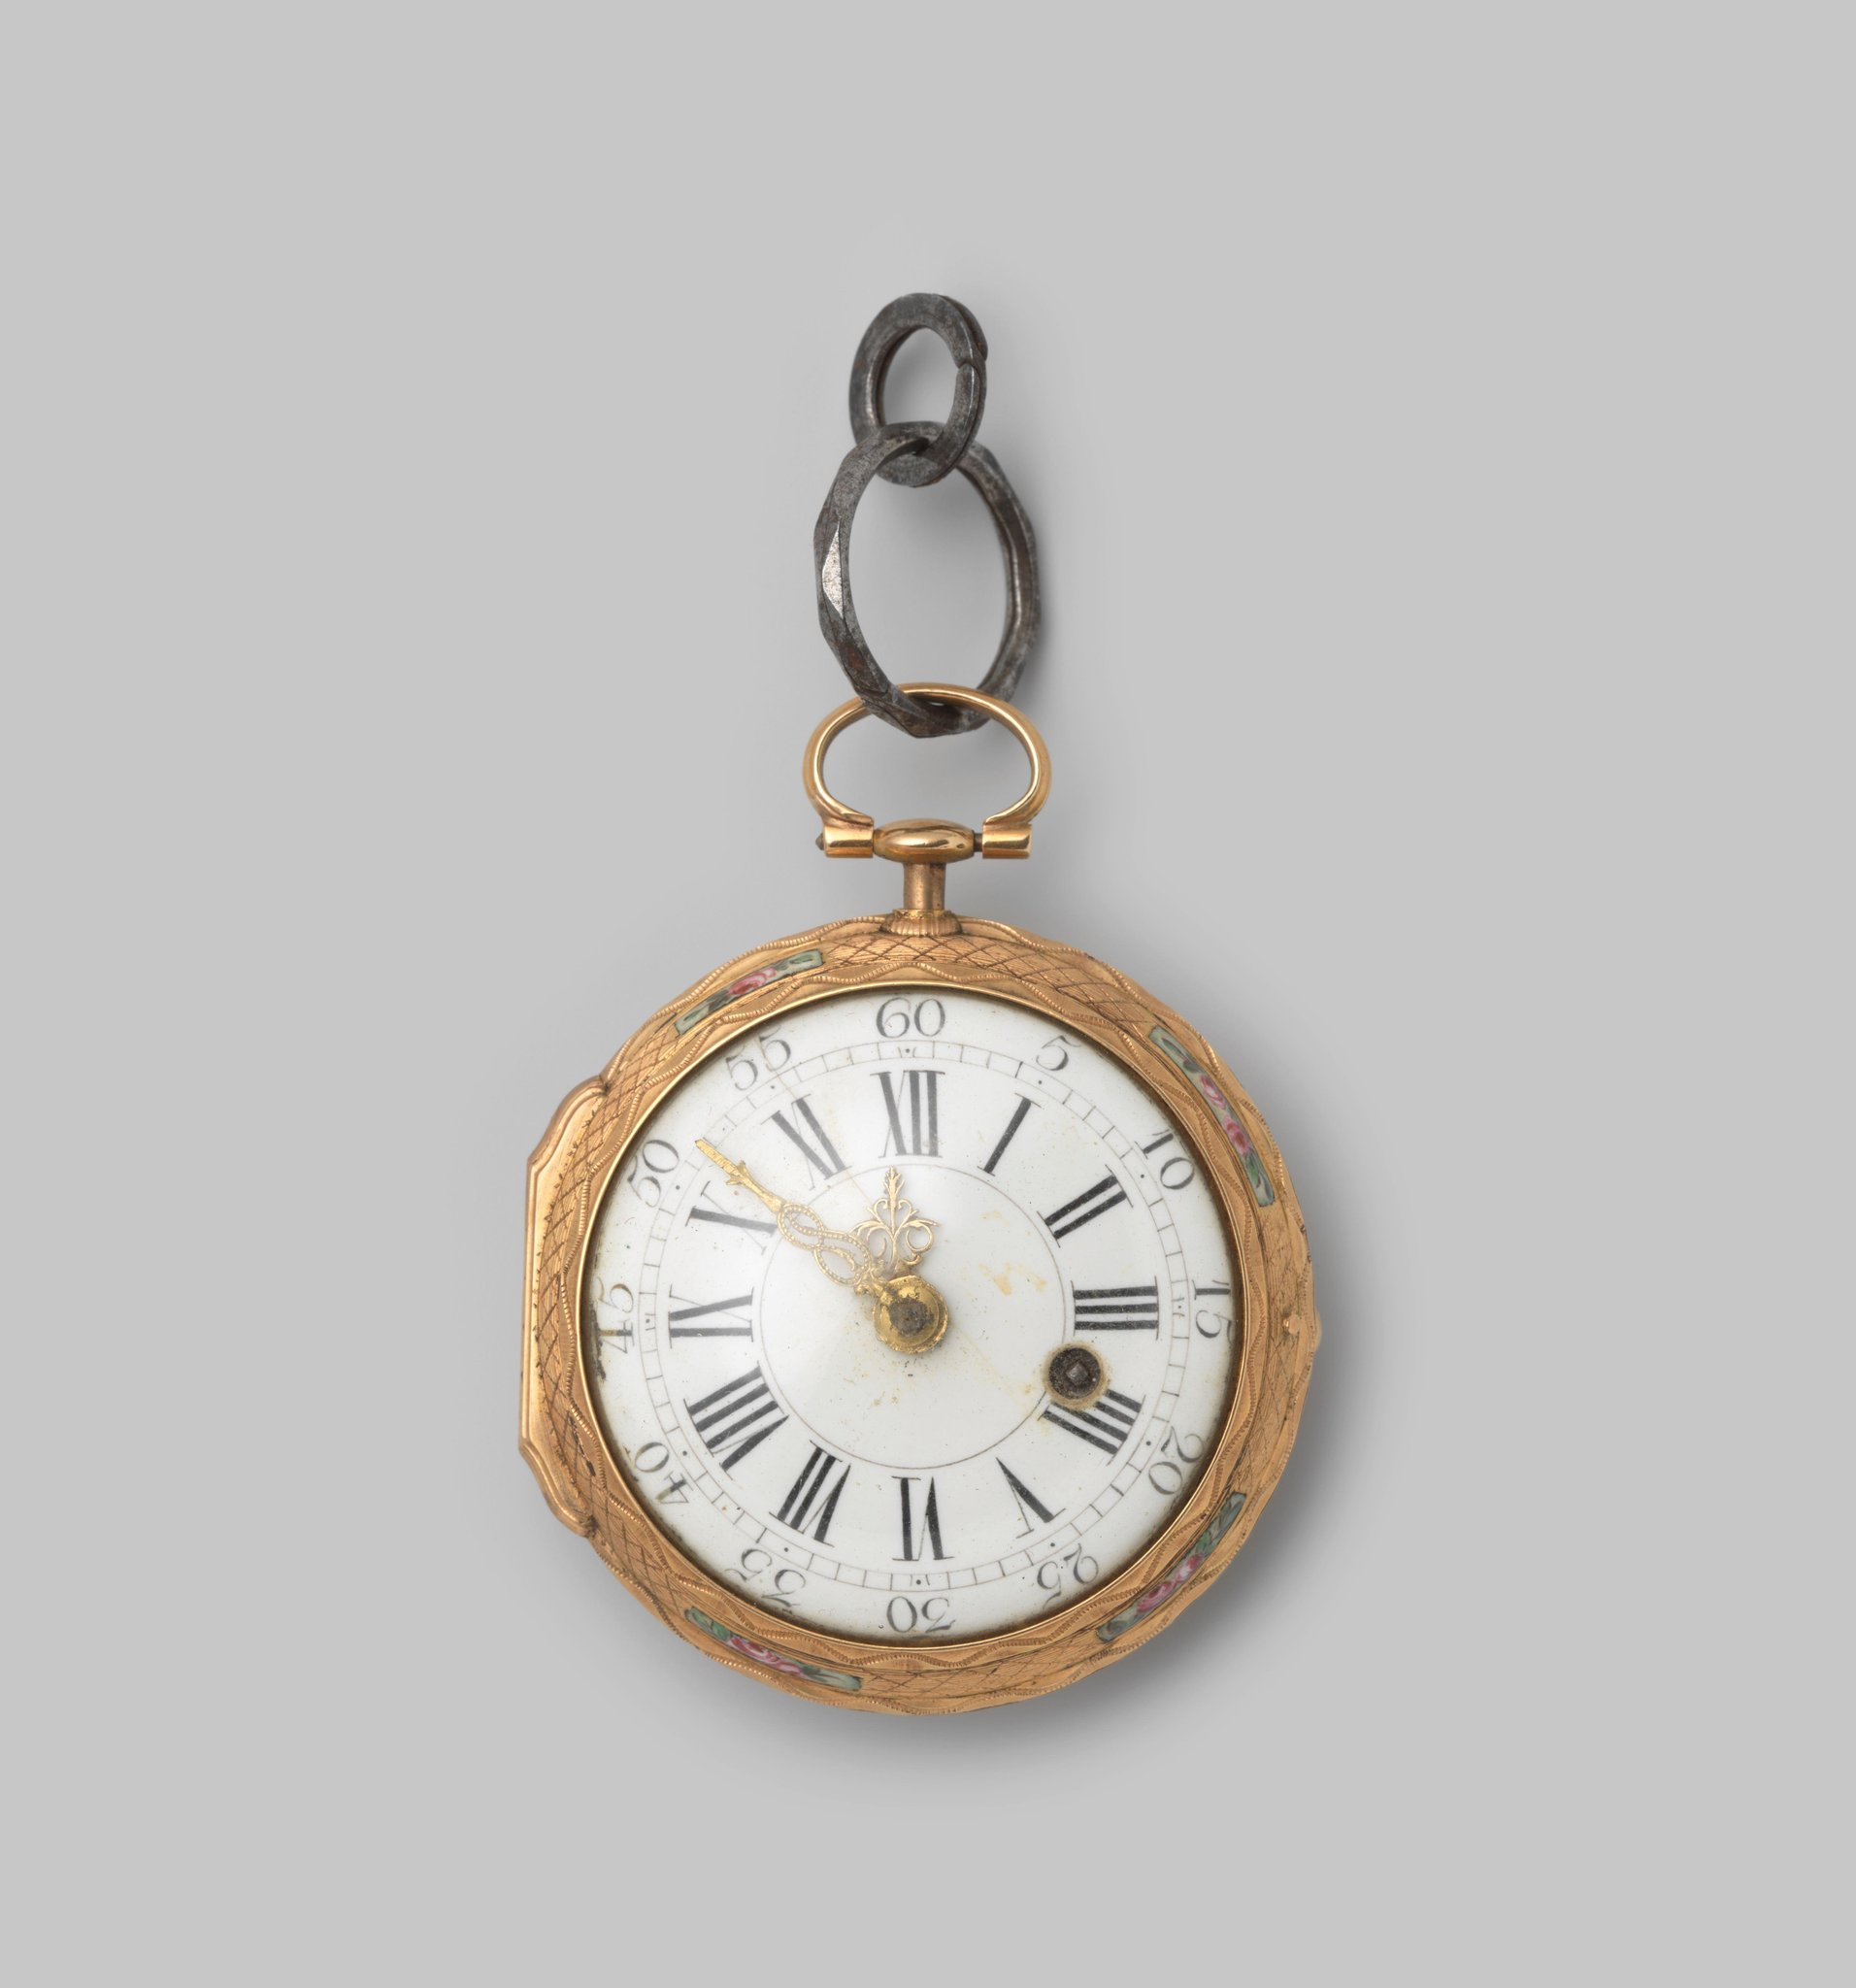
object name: wrist watch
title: Horloge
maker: jean baptiste baillon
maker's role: horlogemaker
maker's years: 1715-1772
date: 1727-1773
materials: gold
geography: paris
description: Horloge van goud met een geëmailleerde voorstelling op de kast.